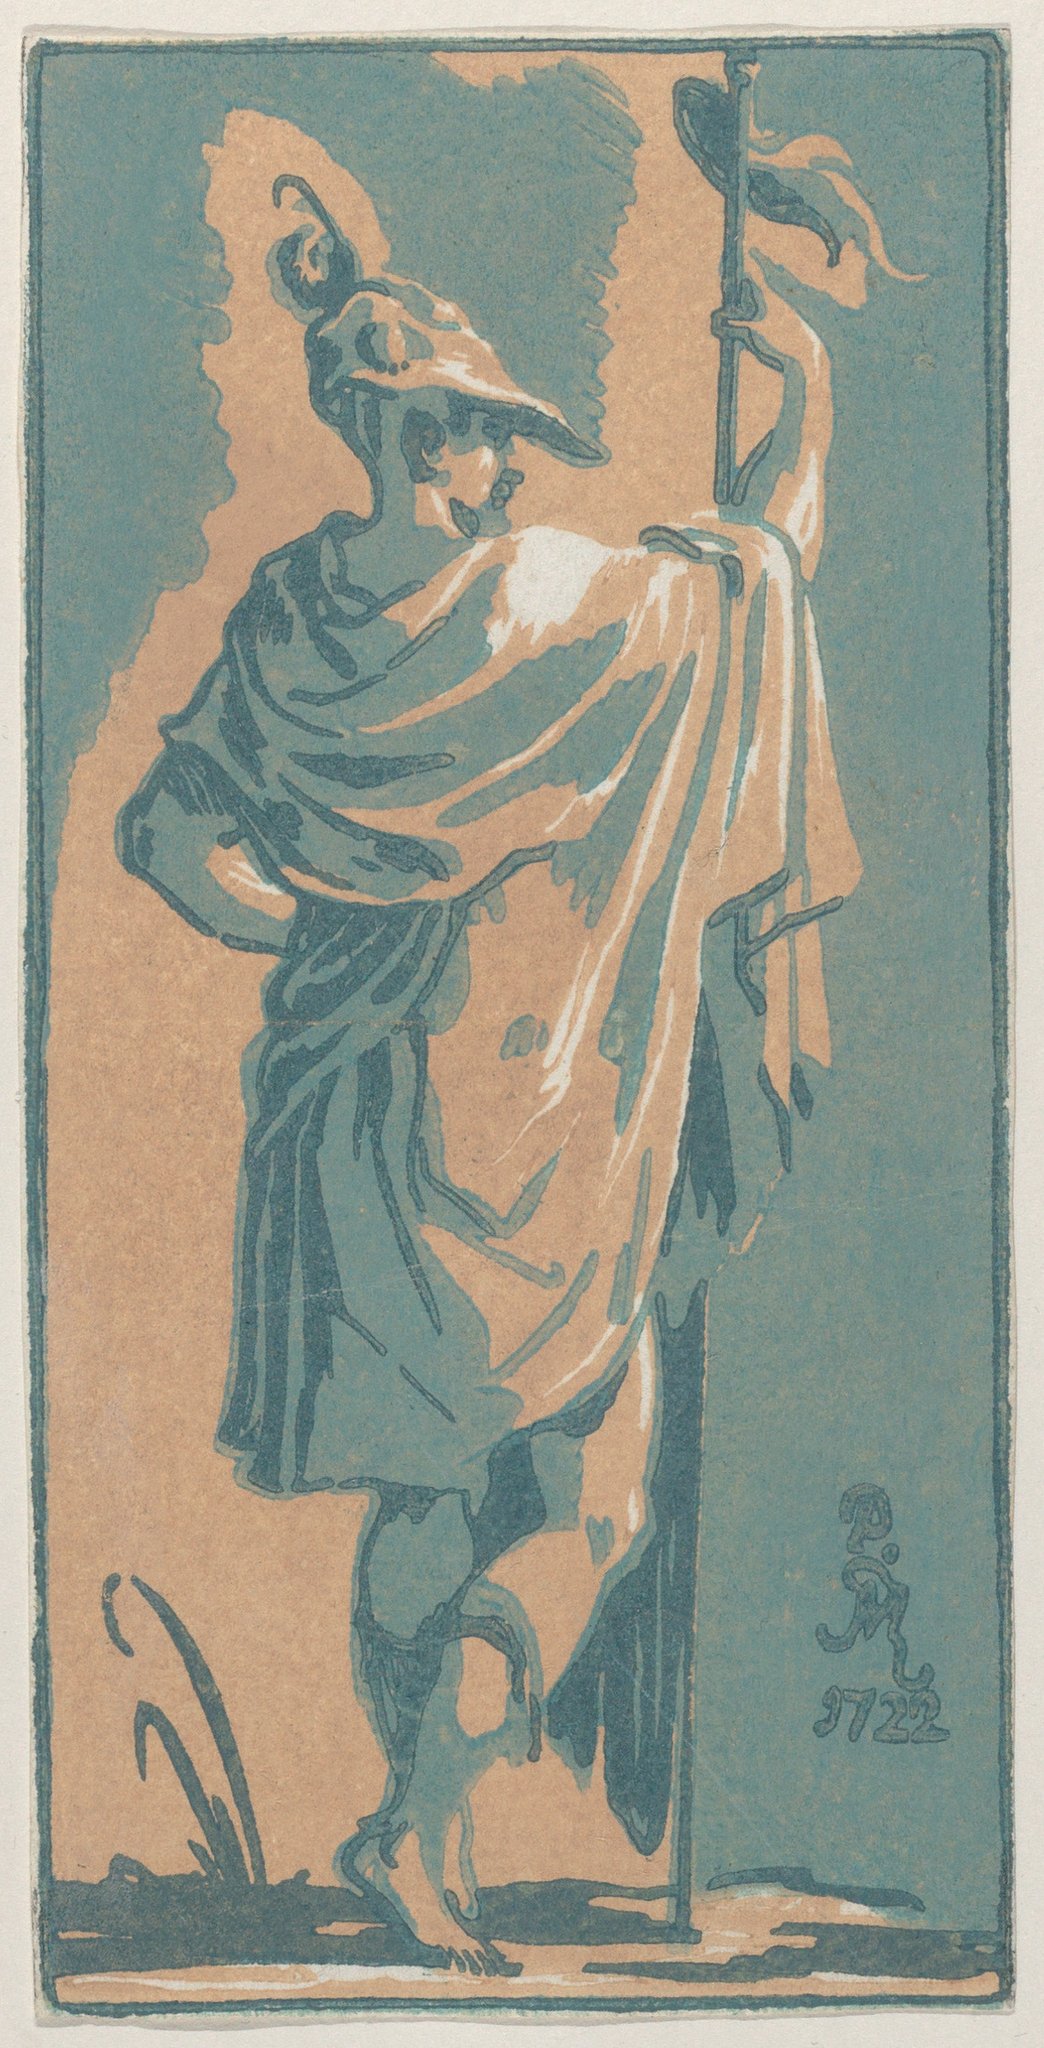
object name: print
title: The Apostle Saint James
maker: conte anton maria zanetti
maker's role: artist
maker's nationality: italian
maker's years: 1680-1767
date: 1722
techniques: woodcut